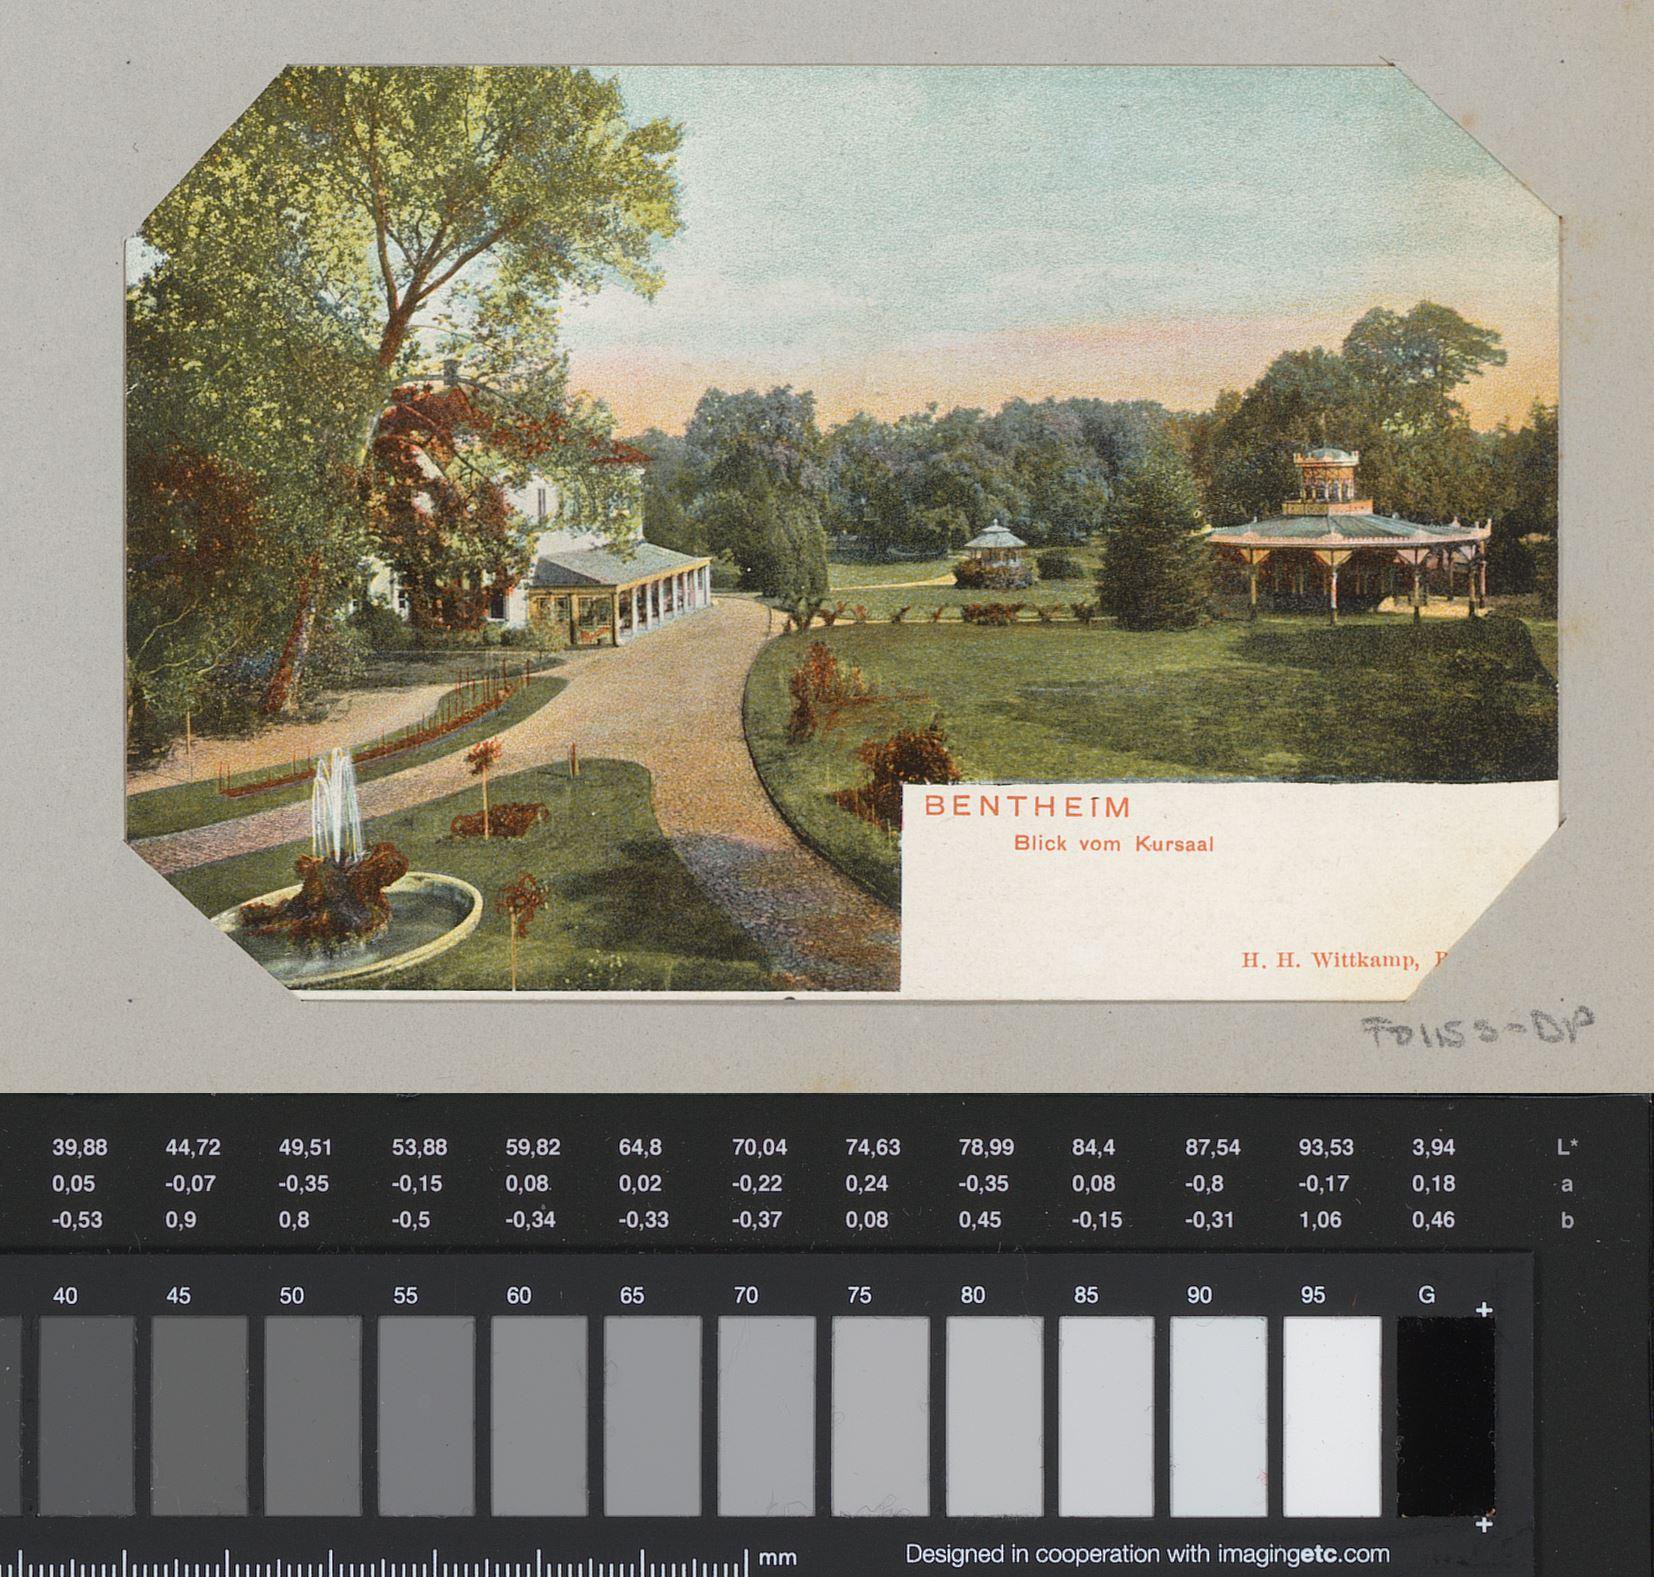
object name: photomechanical print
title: Gezicht op het Kurpark te Bad Bentheim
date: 1895-1903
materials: cardboard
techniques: four-color autotype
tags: watering-place, spa, garden buildings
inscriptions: inscription: ‘Bentheim/ BLick vom Kursaal/ H.H. Wittkamp, Bentheim’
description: Deze prent maakt deel uit van een album.